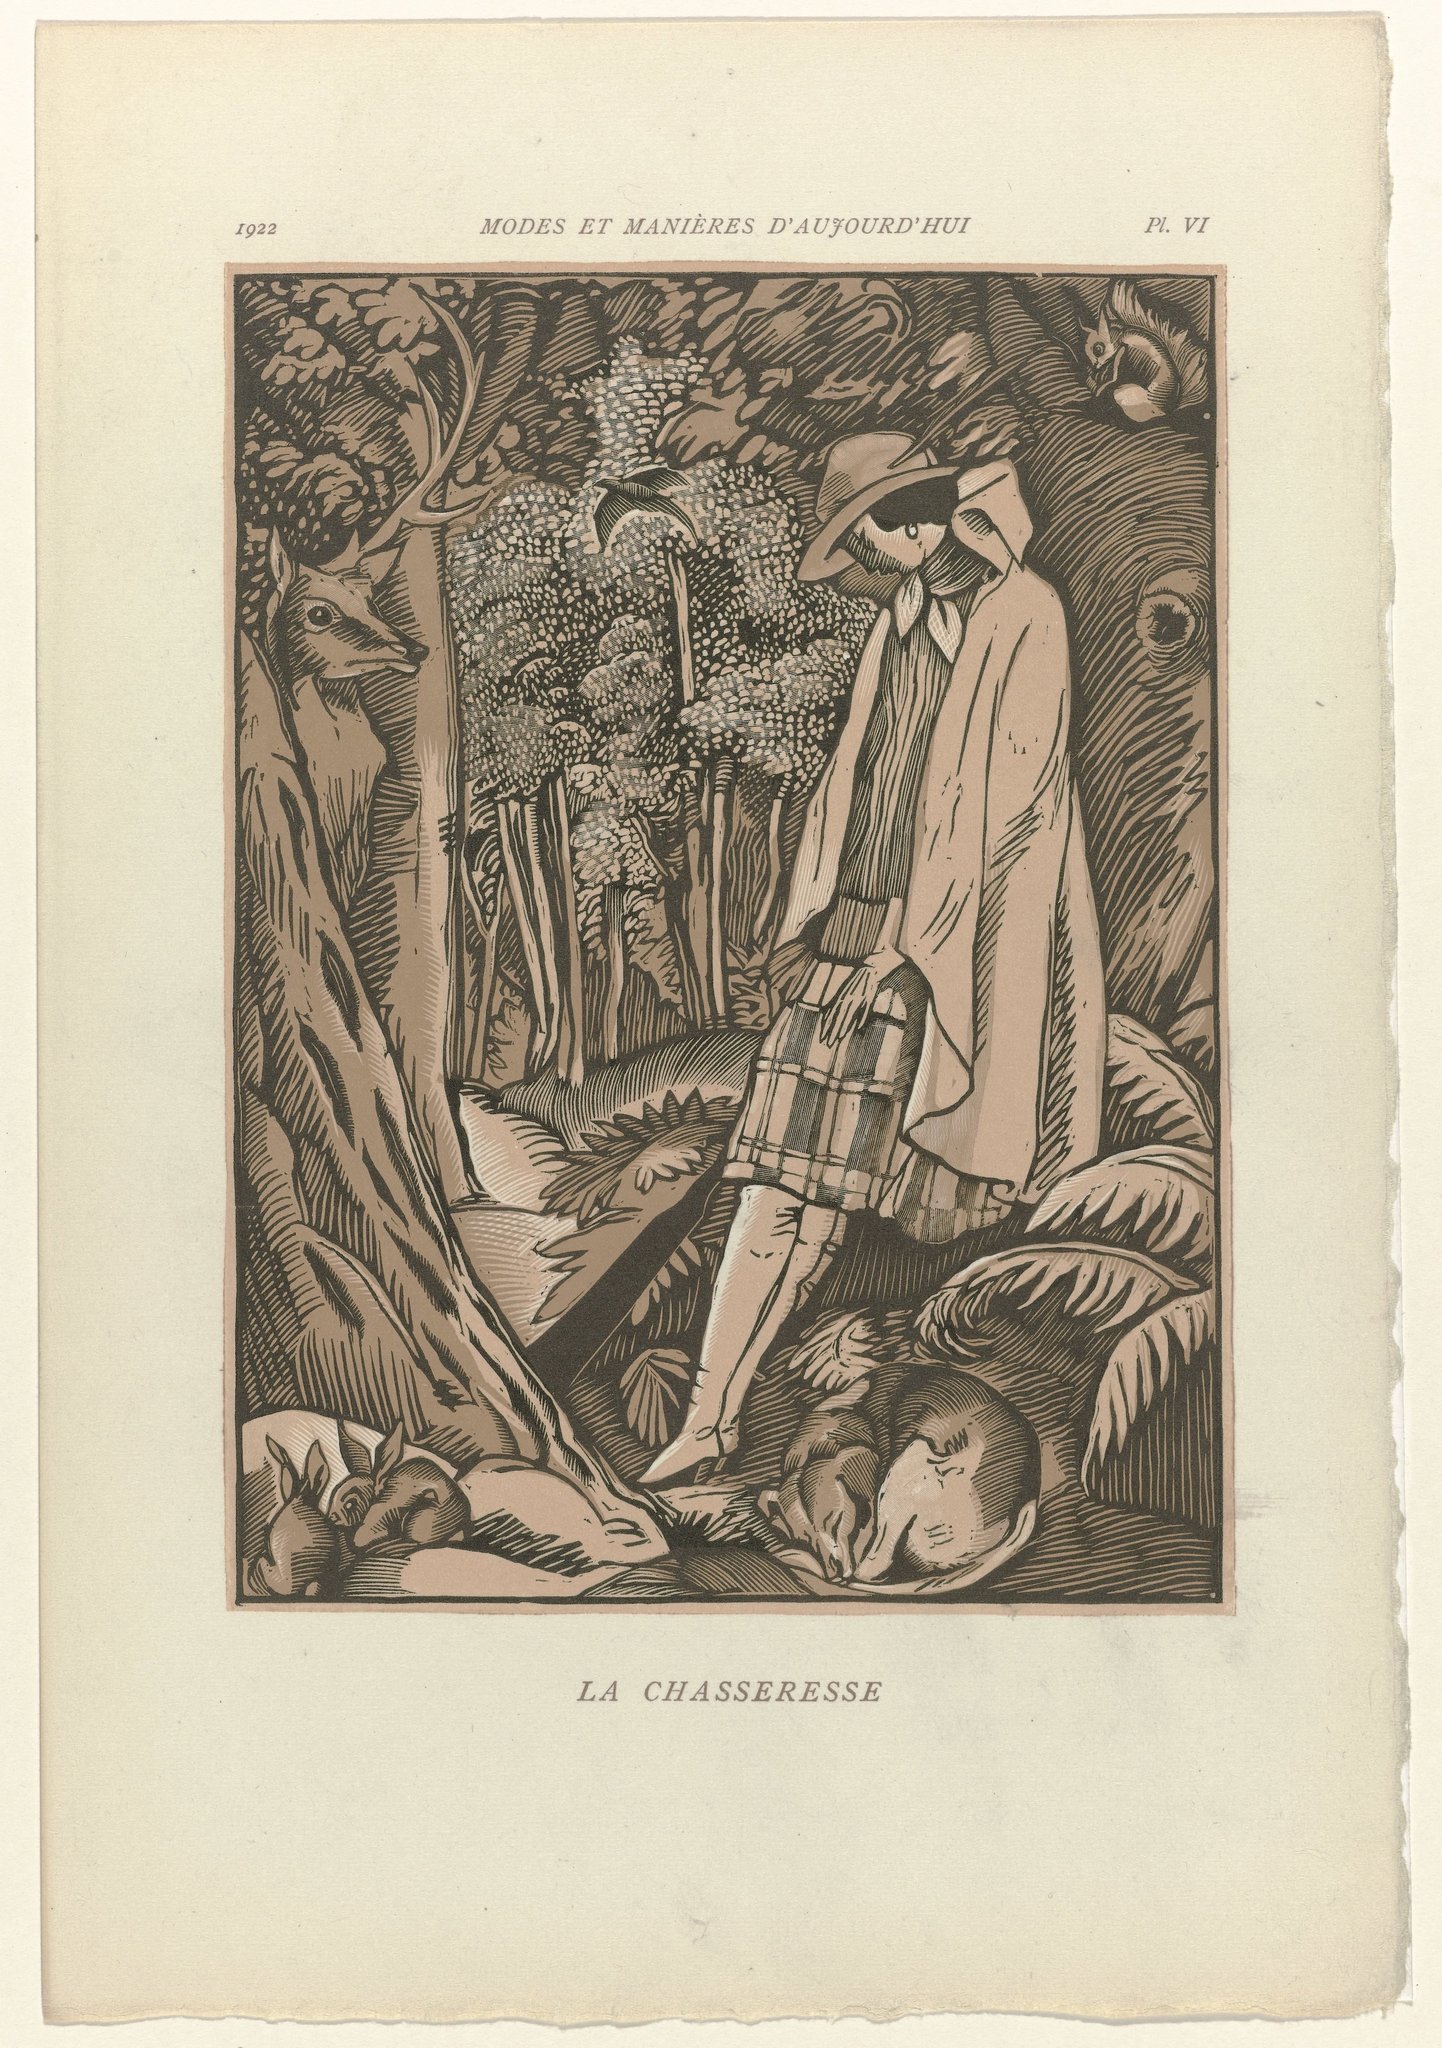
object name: fashion print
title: Modes et Manières d'Aujourd'hui, 1922, Pl. 6 : La Chasseresse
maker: Anonymous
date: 1922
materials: paper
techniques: pochoir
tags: hoofed animals: deer, coat (+ women's clothes), fashion plates, head-gear: hat (+ women's clothes), forest, wood, hunter - cc - female hunter, huntress, rodents: squirrel, rodents: rabbit, dog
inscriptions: title: ‘MODES ET MANIÈRES D'AUJOURD'HUI’, caption: ‘LA CHASSERESSE’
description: Een jagerin staat met het hoofd gebogen tegen een boom aan. Zij draagt een cape met grote opstaande kraag op een gestreepte top en geruite rok. Om haar heen verschillende dieren, waaronder een hert, eekhoorn, twee konijnen, vogel en hond. De prent maakt deel uit van een serie van 12 houtsneden van Fernand Siméon, met teksten van Paul Valery, voor het zevende deel (10e année 1922) van Modes et Manières d'Aujourd'hui. Elke uitgave had een oplage van slechts 300 stuks en was exclusief gewijd aan één kunstenaar die 12 prenten ontwierp rond een bepaald thema. In deze serie staat het 'leven van de modieuze vrouw in de maatschappij' centraal.